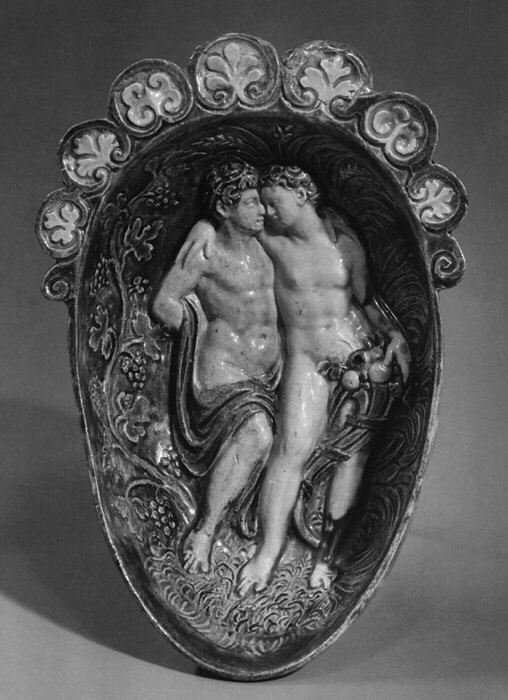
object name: gondola cup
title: Gondola cup (Coupe gondole) with Bacchus and Ceres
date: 1601-1633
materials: earthenware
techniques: glazing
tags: bacchus,ceres